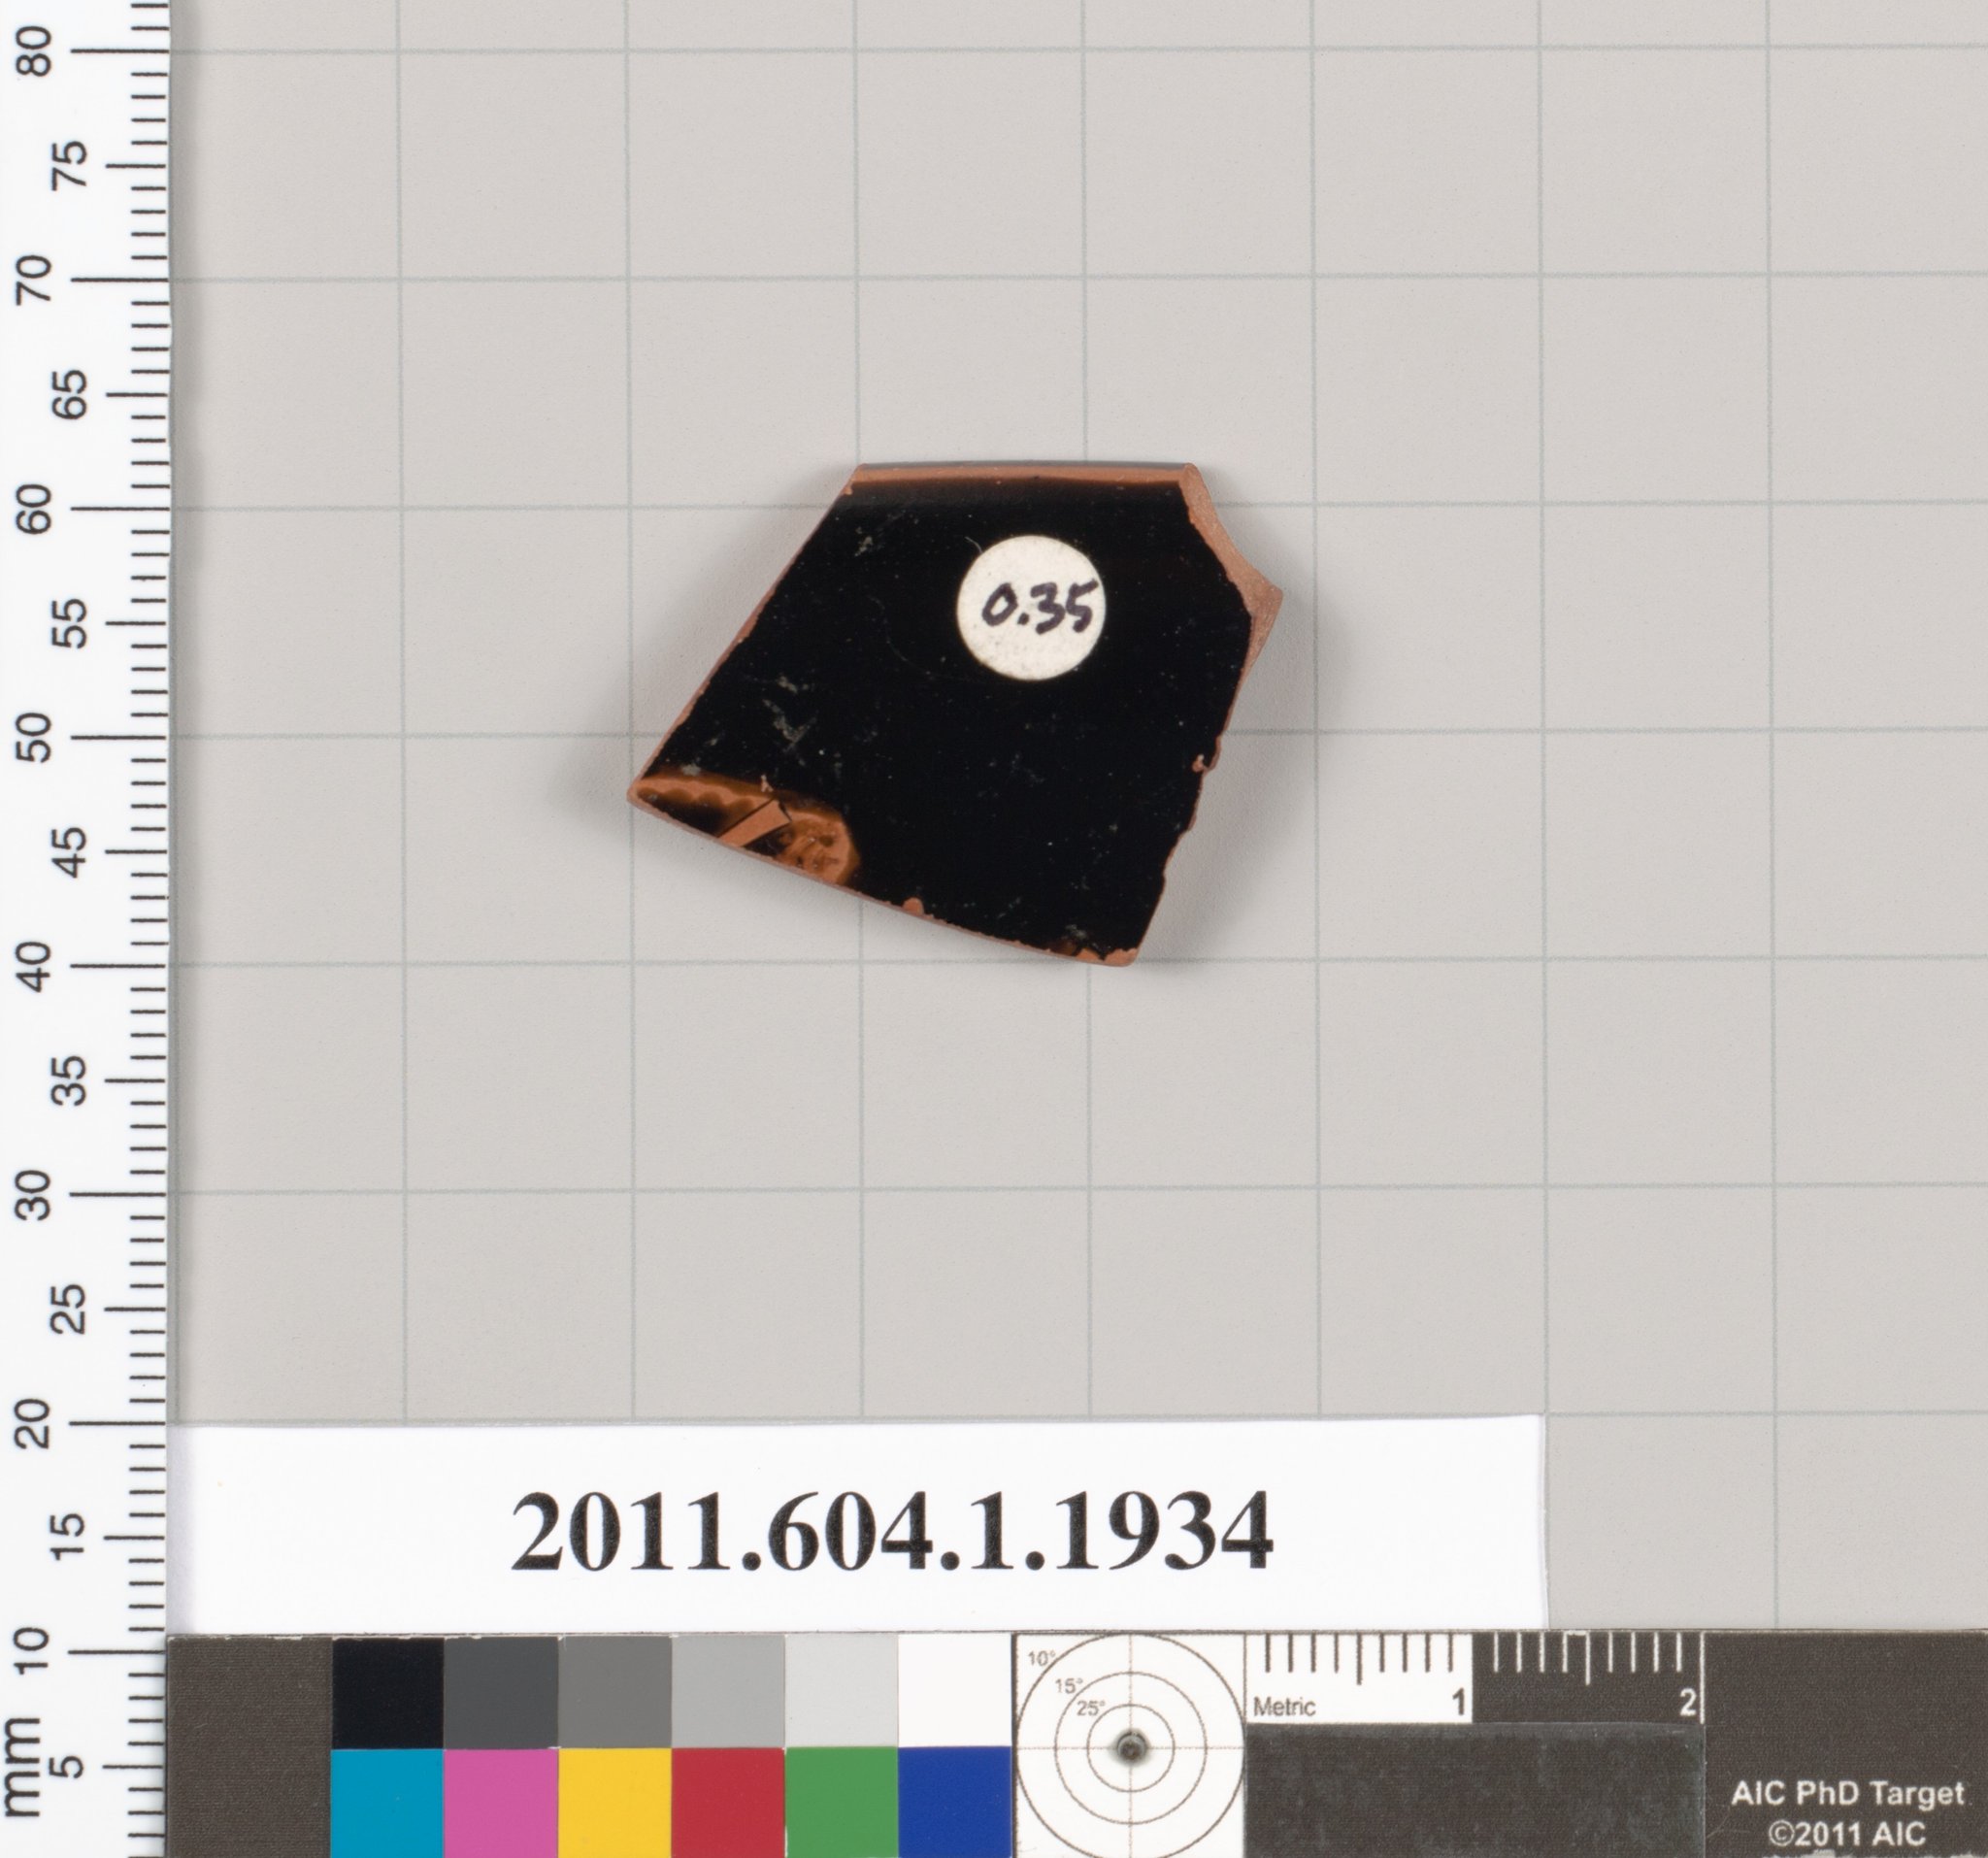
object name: kylix fragment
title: Terracotta rim fragment of a kylix (drinking cup)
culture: greek, attic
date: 470-450 BCE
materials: terracotta